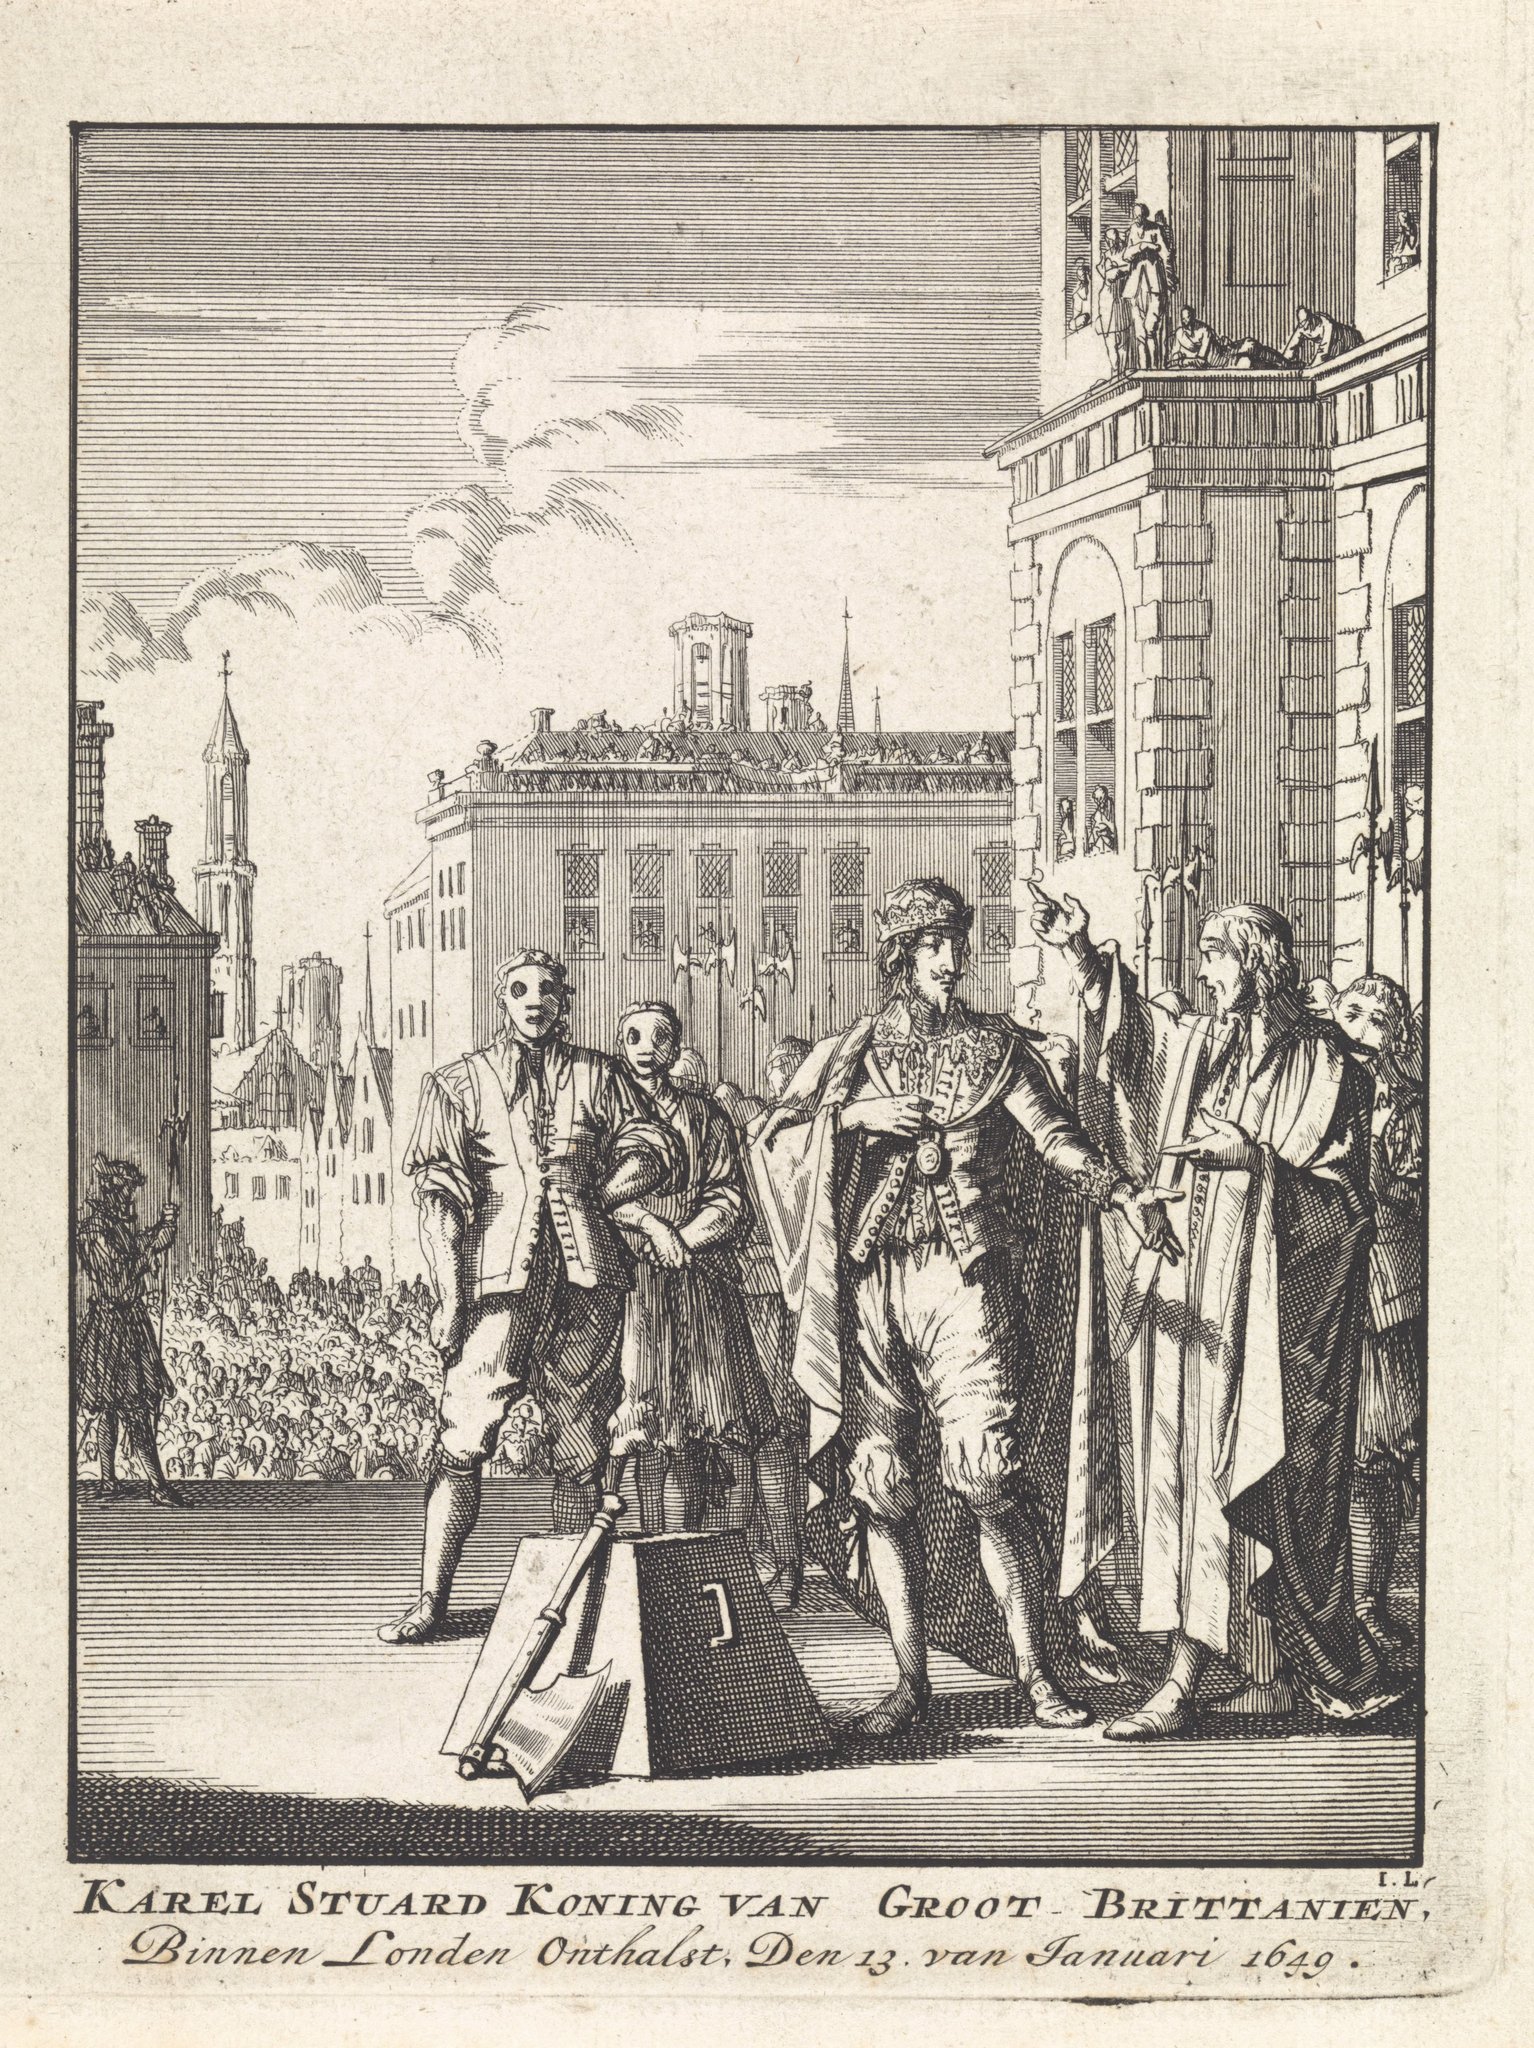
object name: print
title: Karel Stuard Koning van Groot-Brittanien, Binnen Londen Onthalst, Den 13. van januari 1649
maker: jan luyken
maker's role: draughtsman, print maker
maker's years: 1649-1712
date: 1698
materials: paper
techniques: etching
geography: amsterdam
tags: london, karel i (koning van engeland), violent death by beheading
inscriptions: collector's mark: Lugt 2228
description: Proefdruk van illustratie uit: Bos, Lambert van den. Treur-toonneel der doorluchtige mannen, of Op- en ondergang der grooten, 3 delen. Amsterdam: Jan Claesz ten Hoorn, 1698, dl. II.